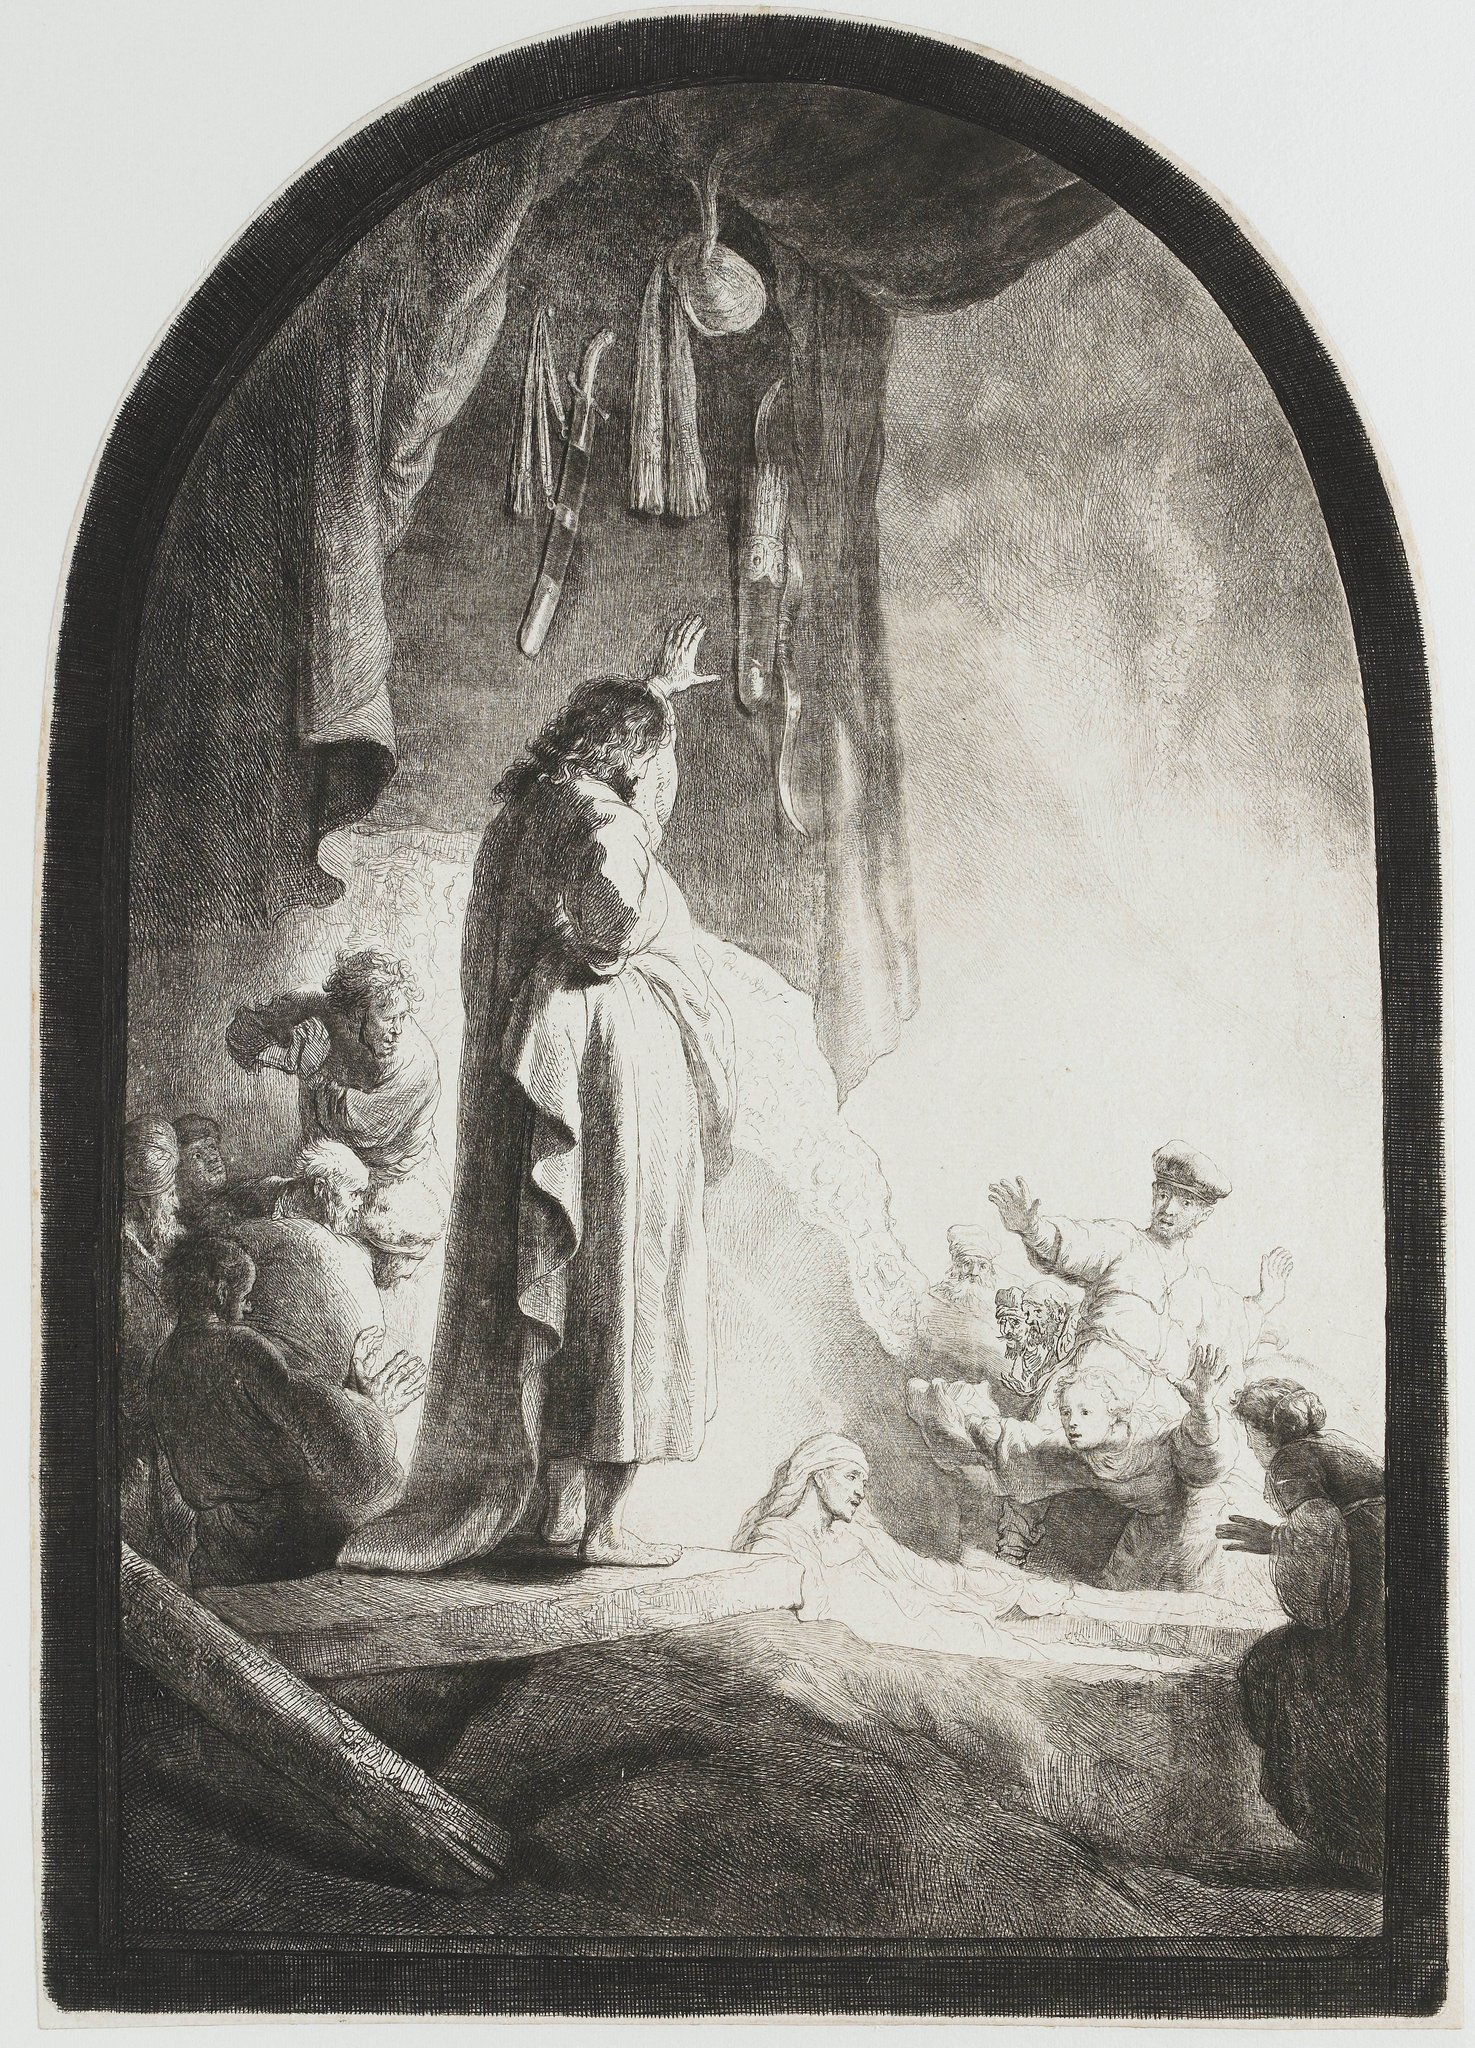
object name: print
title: The raising of Lazarus: the larger plate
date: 1632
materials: paper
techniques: etching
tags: the raising of lazarus ('lazarus, come out')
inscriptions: collector's mark: Lugt 240, signature: ‘RHL. v Rijn f.’